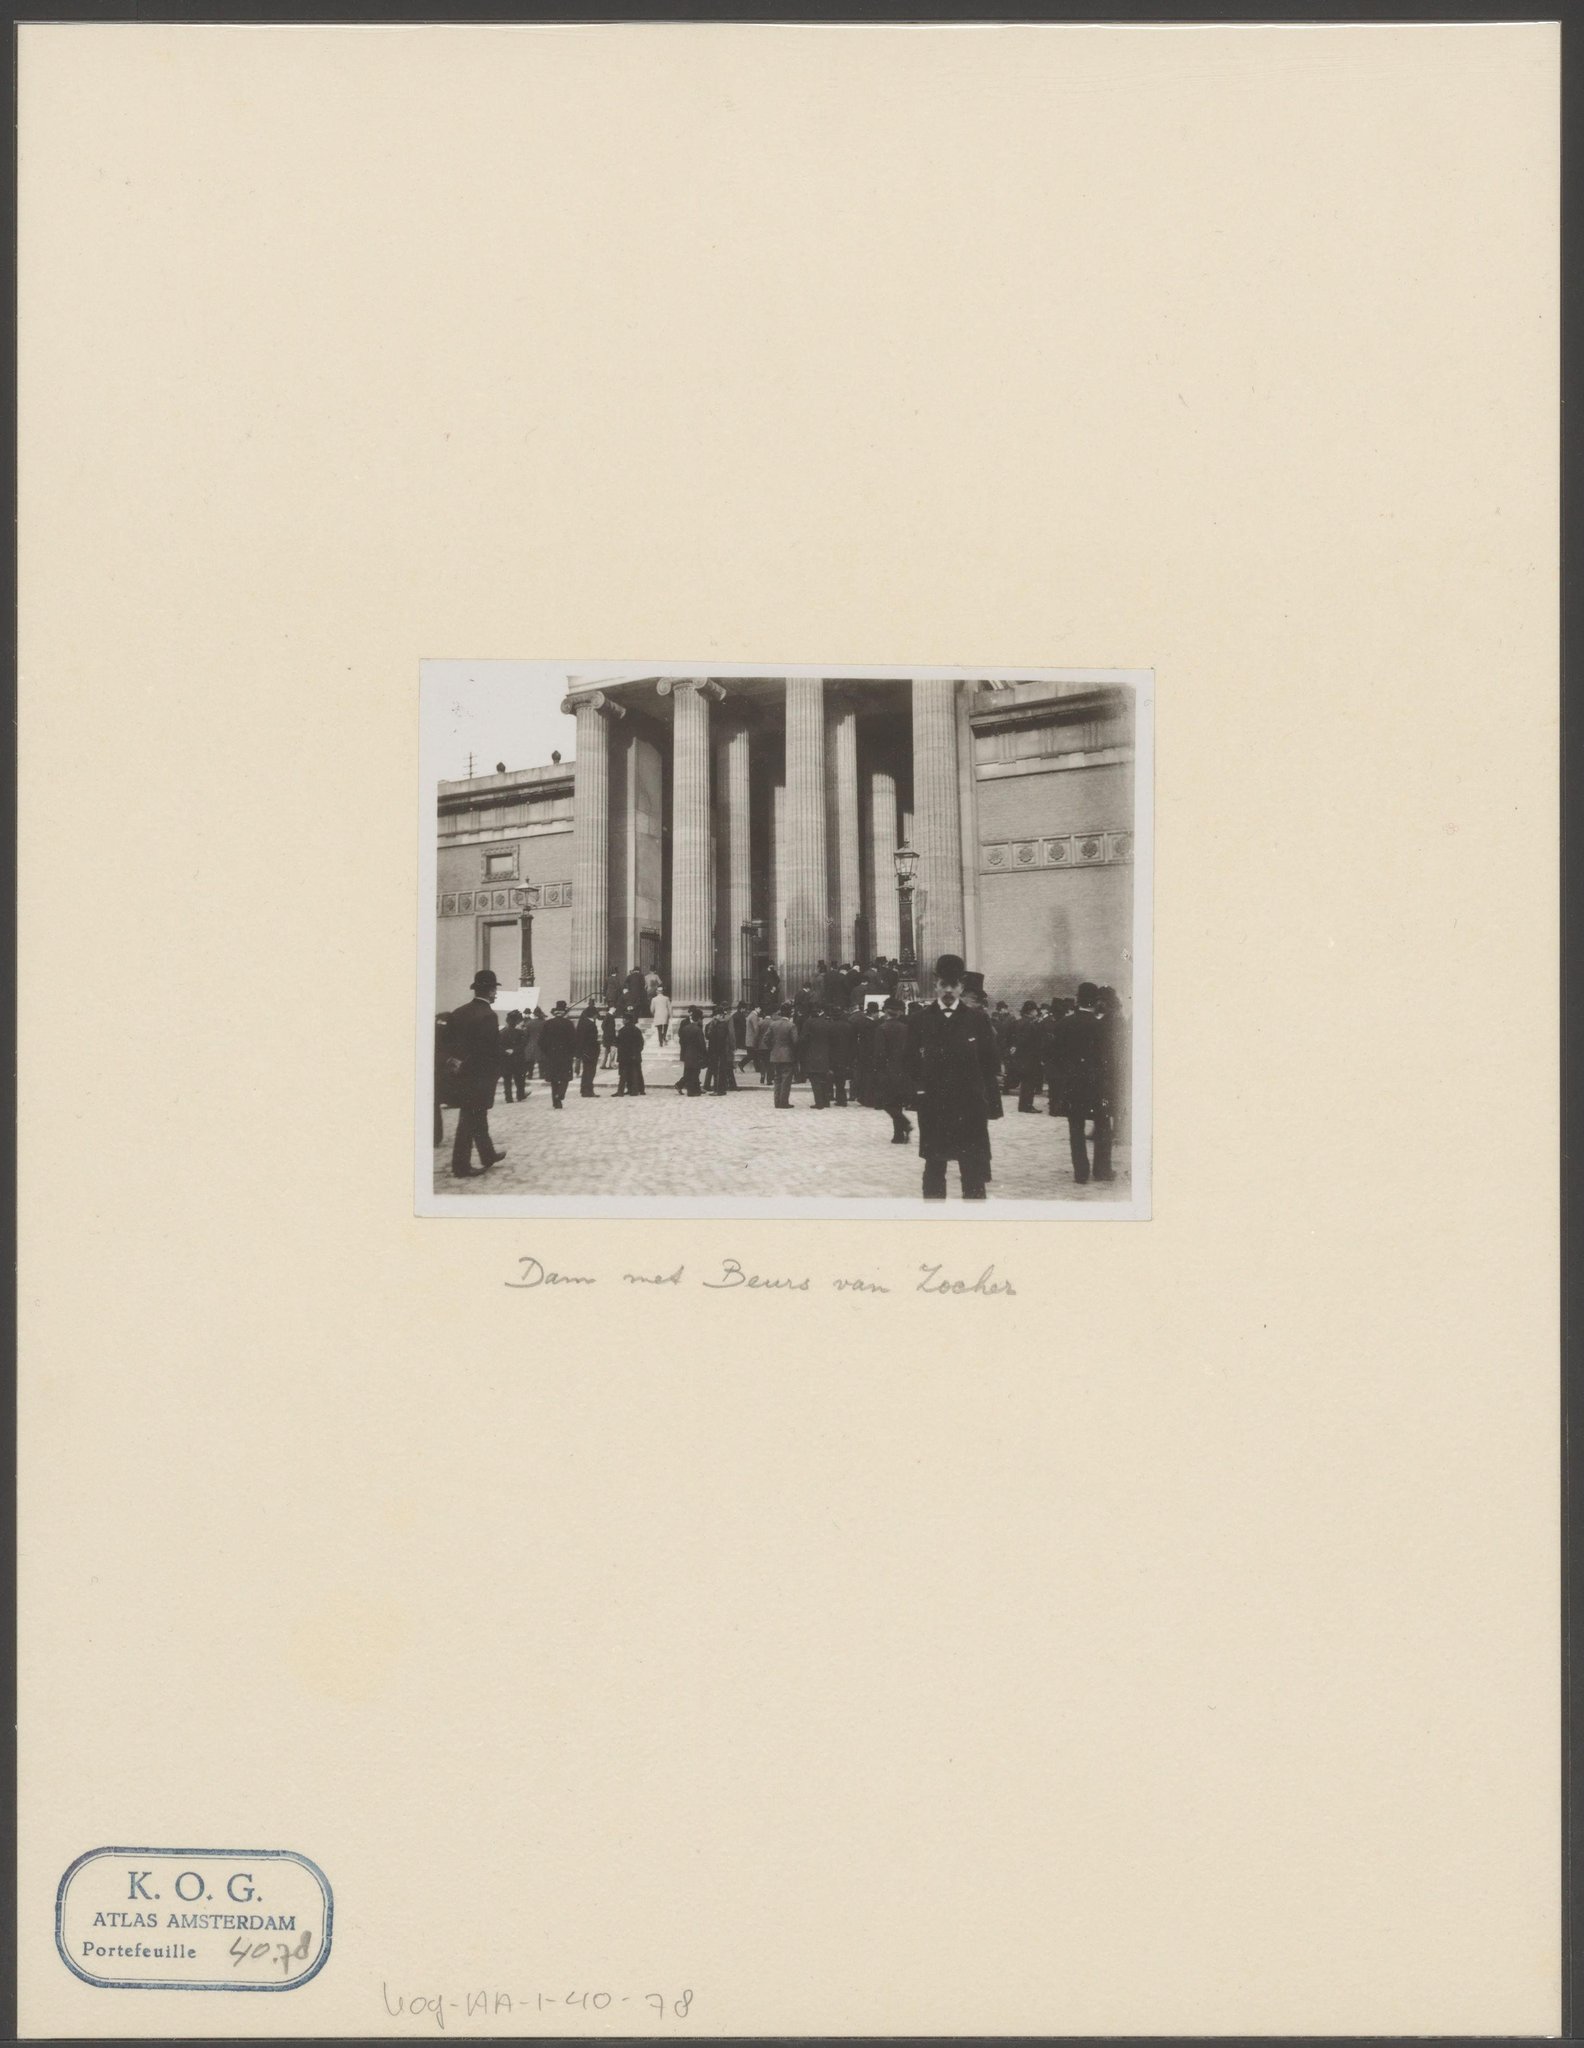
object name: photograph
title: Personen voor de Beurs van Zocher te Amsterdam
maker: Anonymous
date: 1900-1903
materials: paper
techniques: gelatin silver print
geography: netherlands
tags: stock exchange, stock-market, square, place, circus, etc. (+ city(-scape) with figures, staffage)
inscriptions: collector's mark: Lugt 1641b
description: Onderwerpsrubriek binnen de Atlas Amsterdam: Handel en Zeevaart: Hulpbeurs op de Dam en Beurs (Dam).